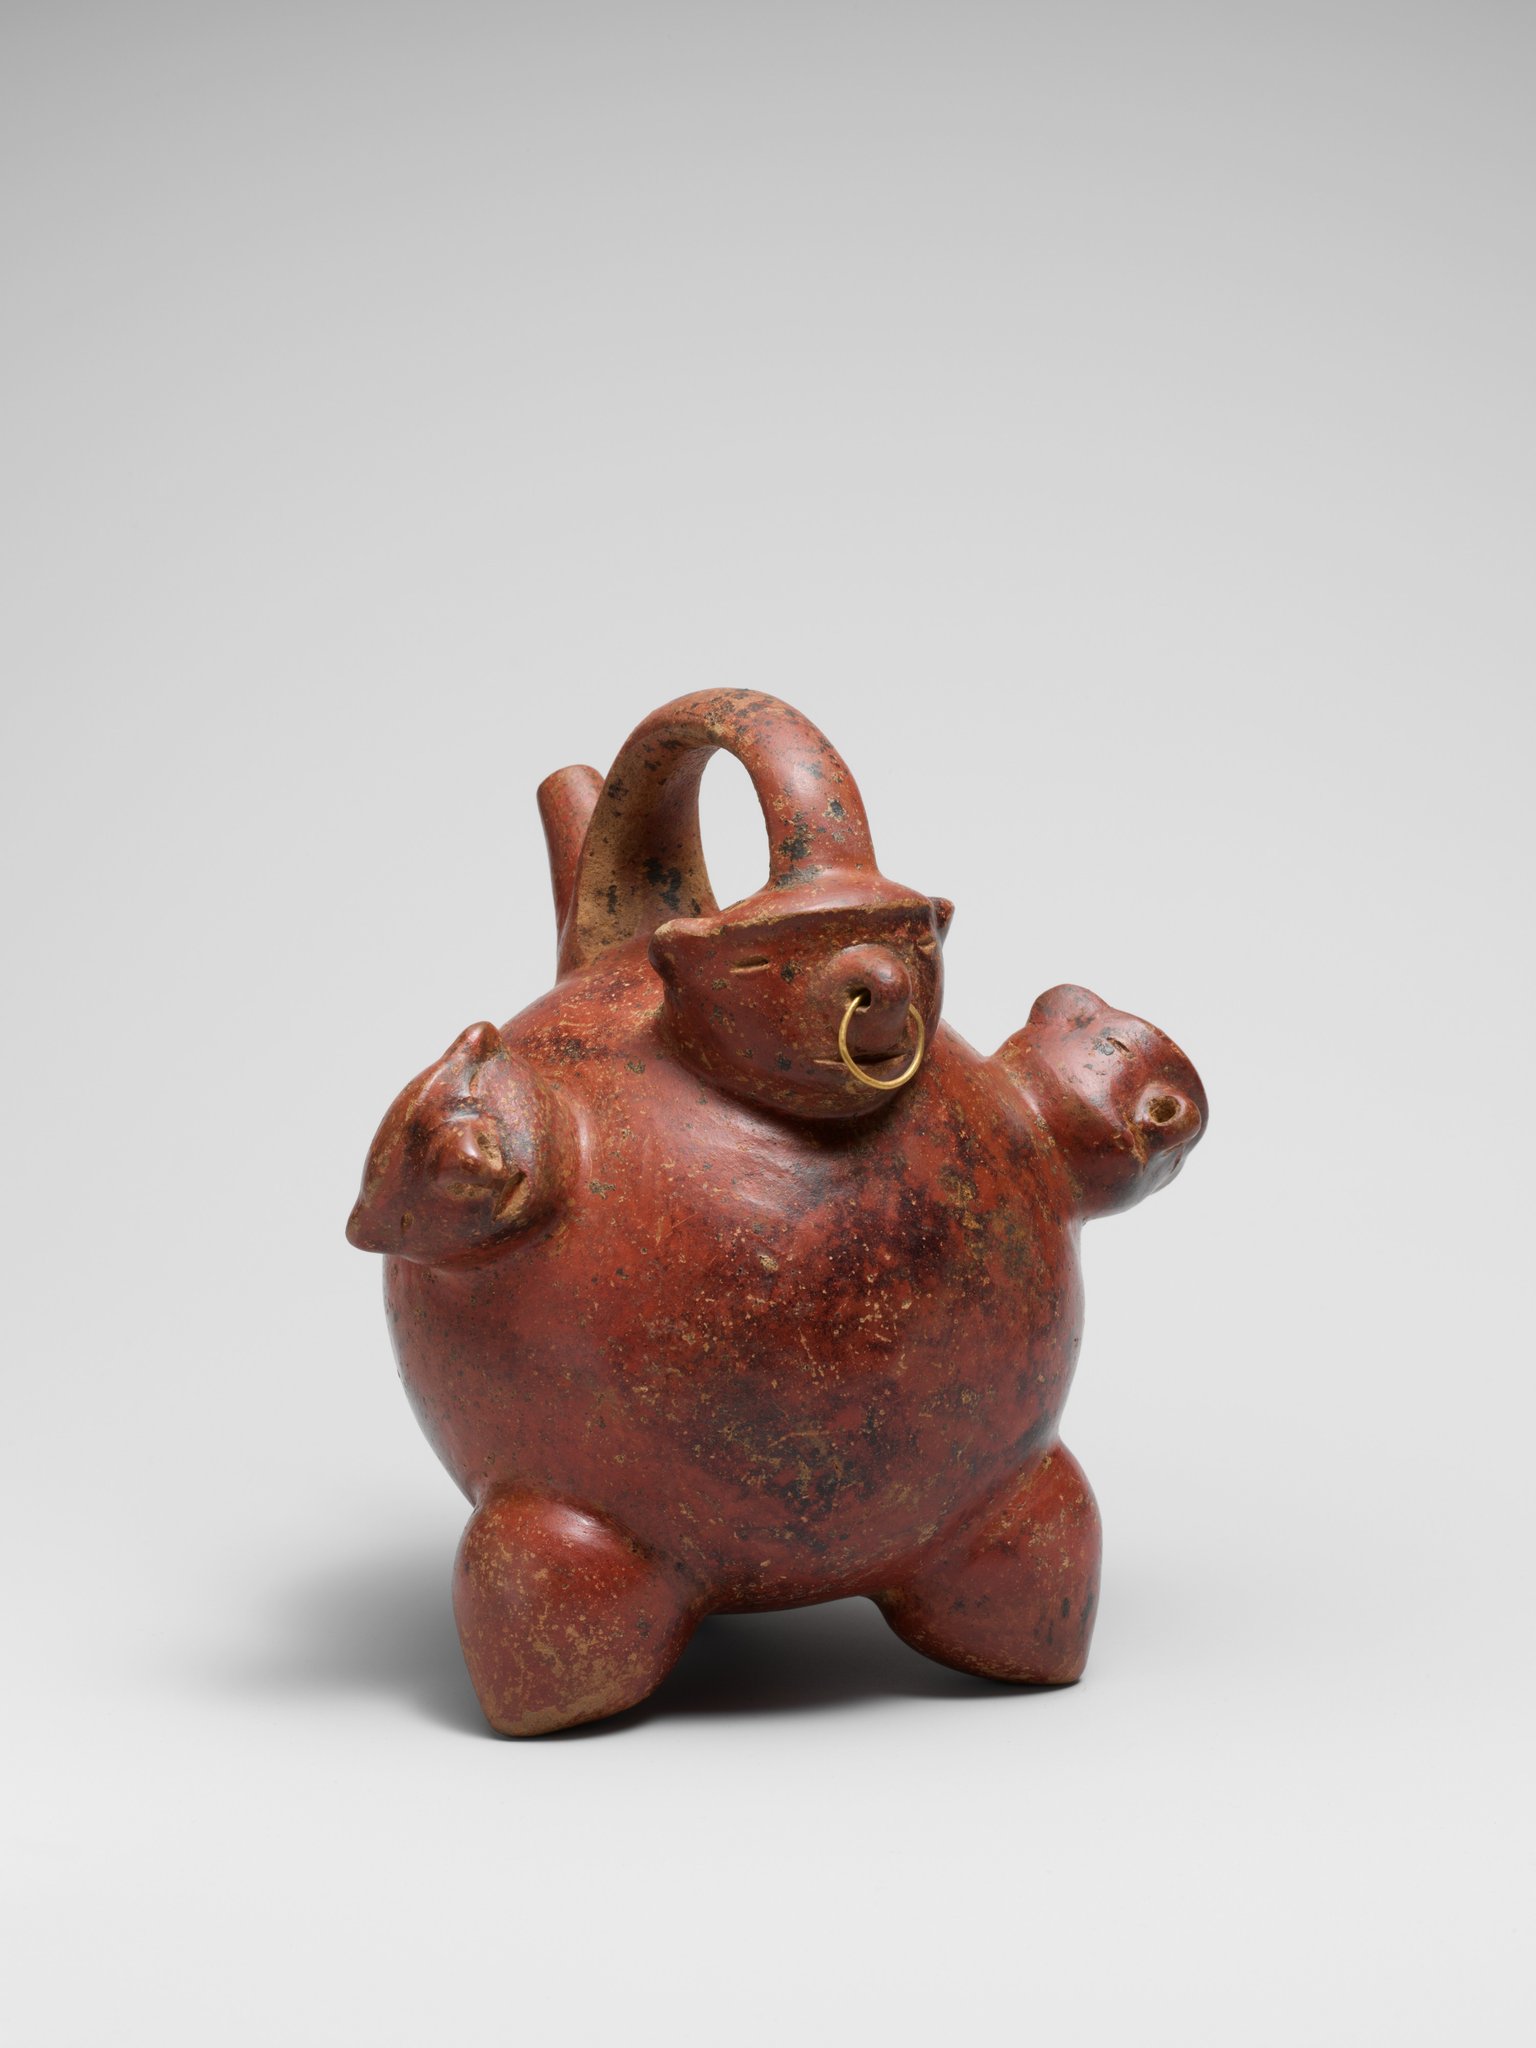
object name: whistling jar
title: Whistle Jar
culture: calima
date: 100-900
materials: ceramic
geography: colombia